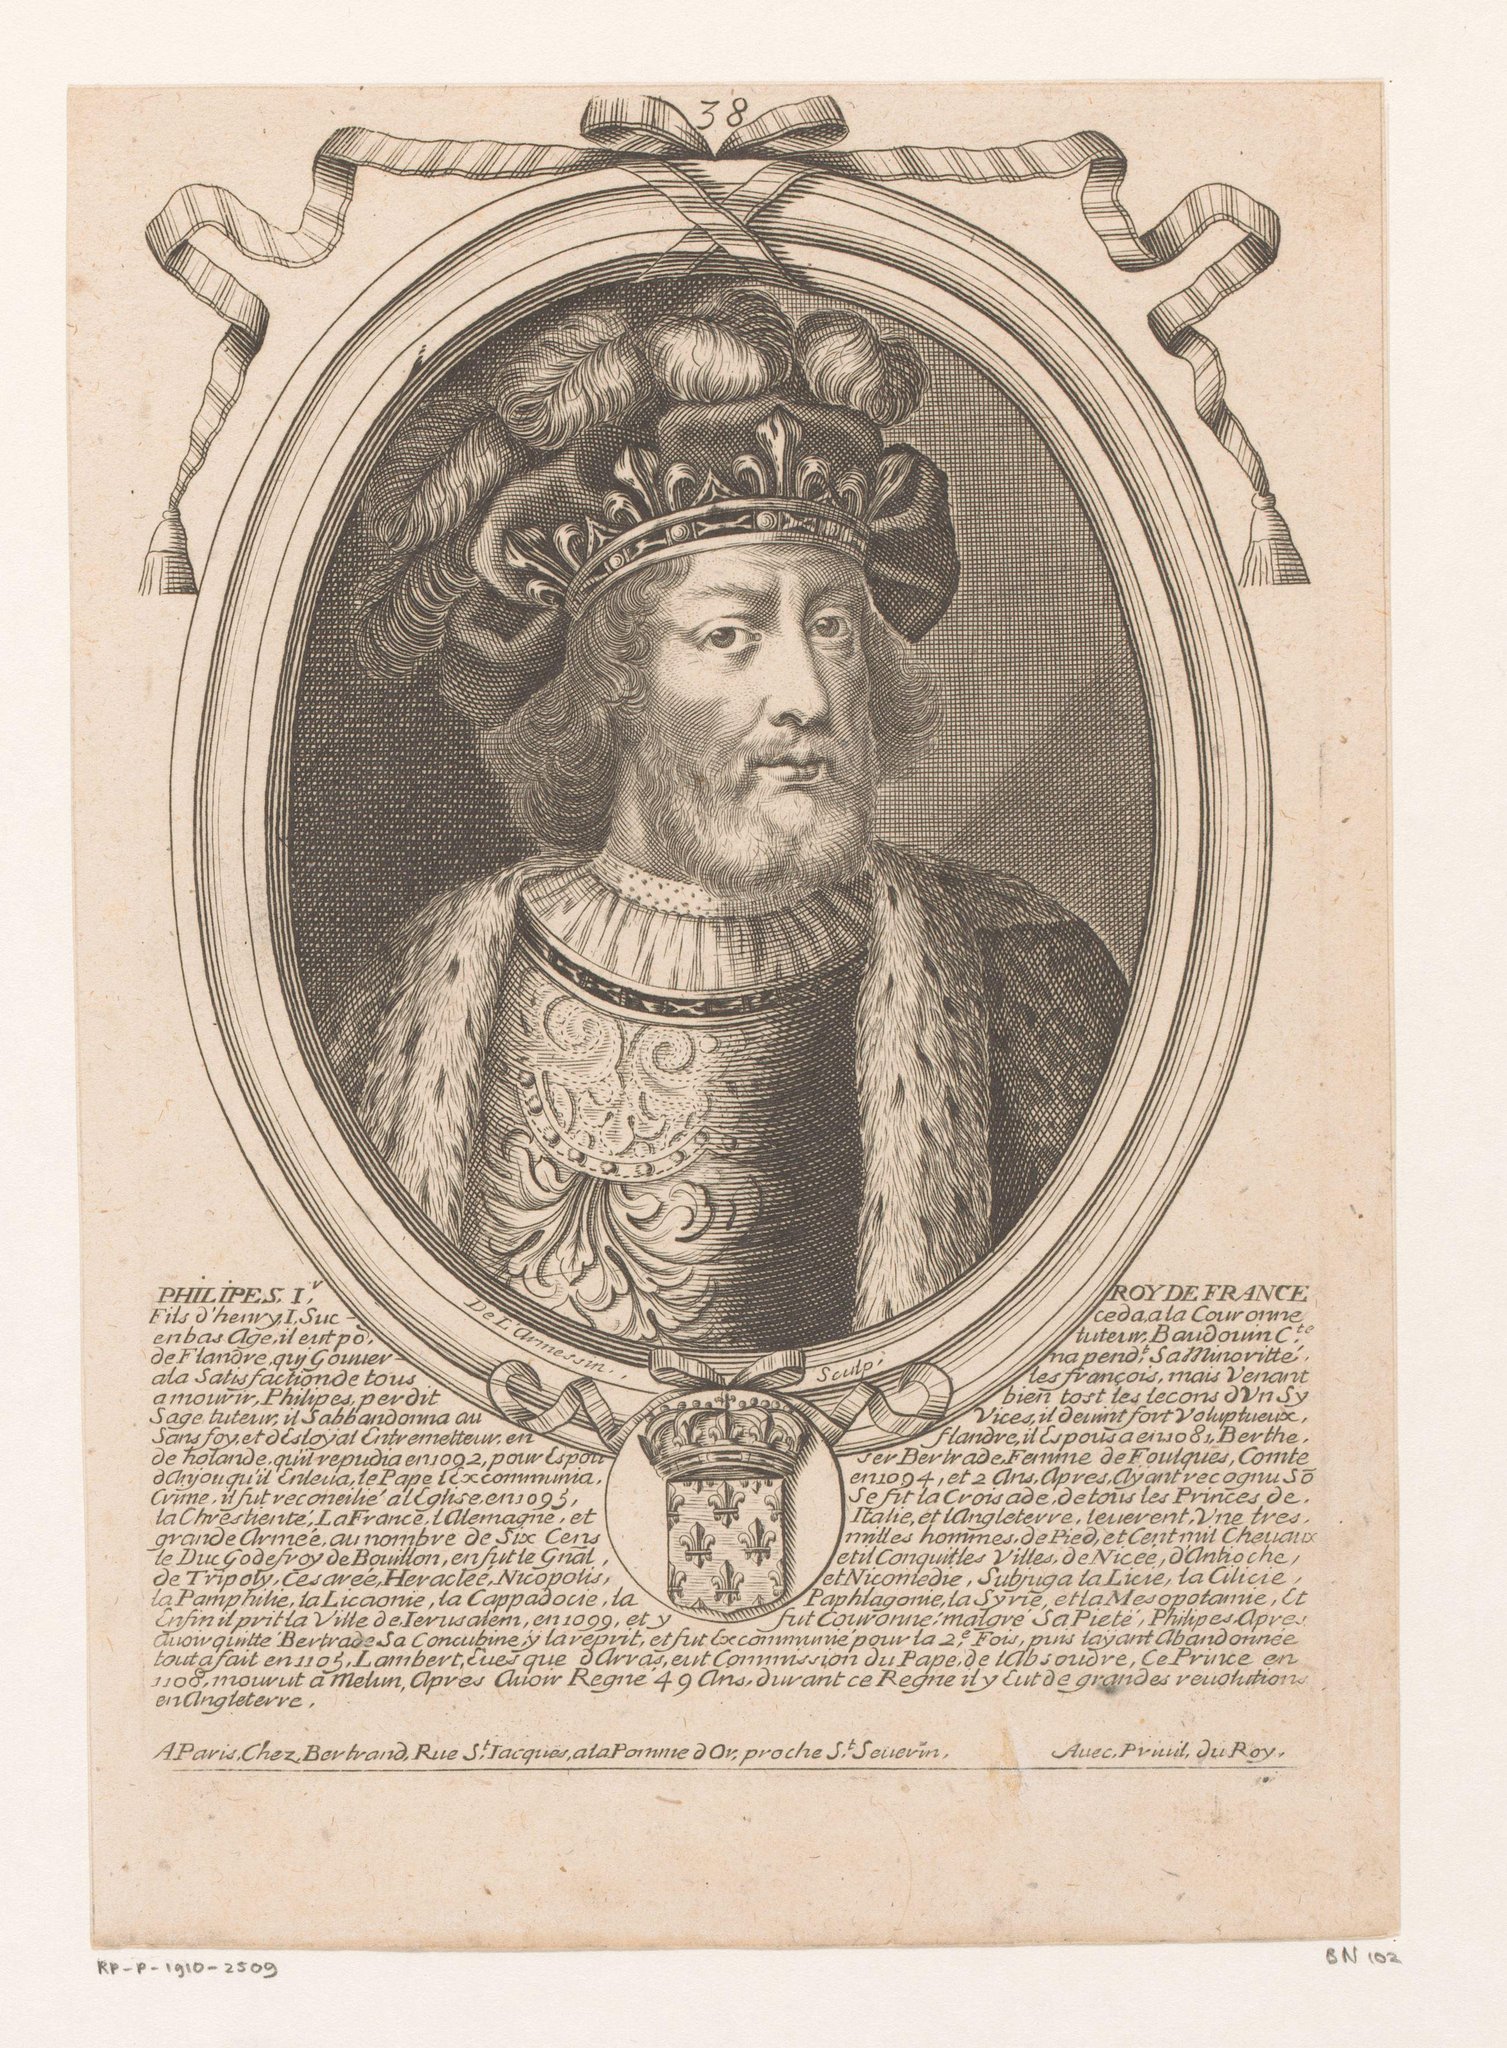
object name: print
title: Portret van Filips I, koning van Frankrijk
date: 1642-1678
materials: paper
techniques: engraving, etching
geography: paris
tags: historical persons, king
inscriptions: collector's mark: Lugt 2228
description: Maakt deel uit van een grootschalige serie met portretten van prominente figuren. Binnen de serie bevindt zich een sectie getiteld 'Les Augustes Représentations De tous les Roys De France depuis Pharamond Iusqu'à Louys XIIII'. De serie werd respectievelijk uitgegeven door Pierre Bertrand, door zijn weduwe en door De Larmessin zelf.